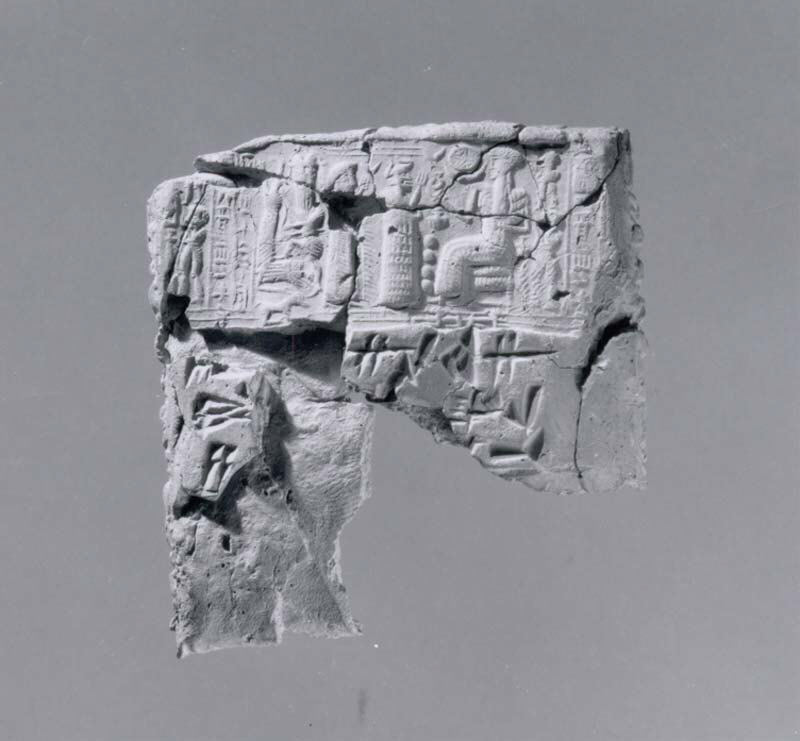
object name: cuneiform tablet case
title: Cuneiform tablet case impressed with four cylinder seals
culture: assyrian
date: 2000-1801 BCE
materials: clay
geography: anatolia